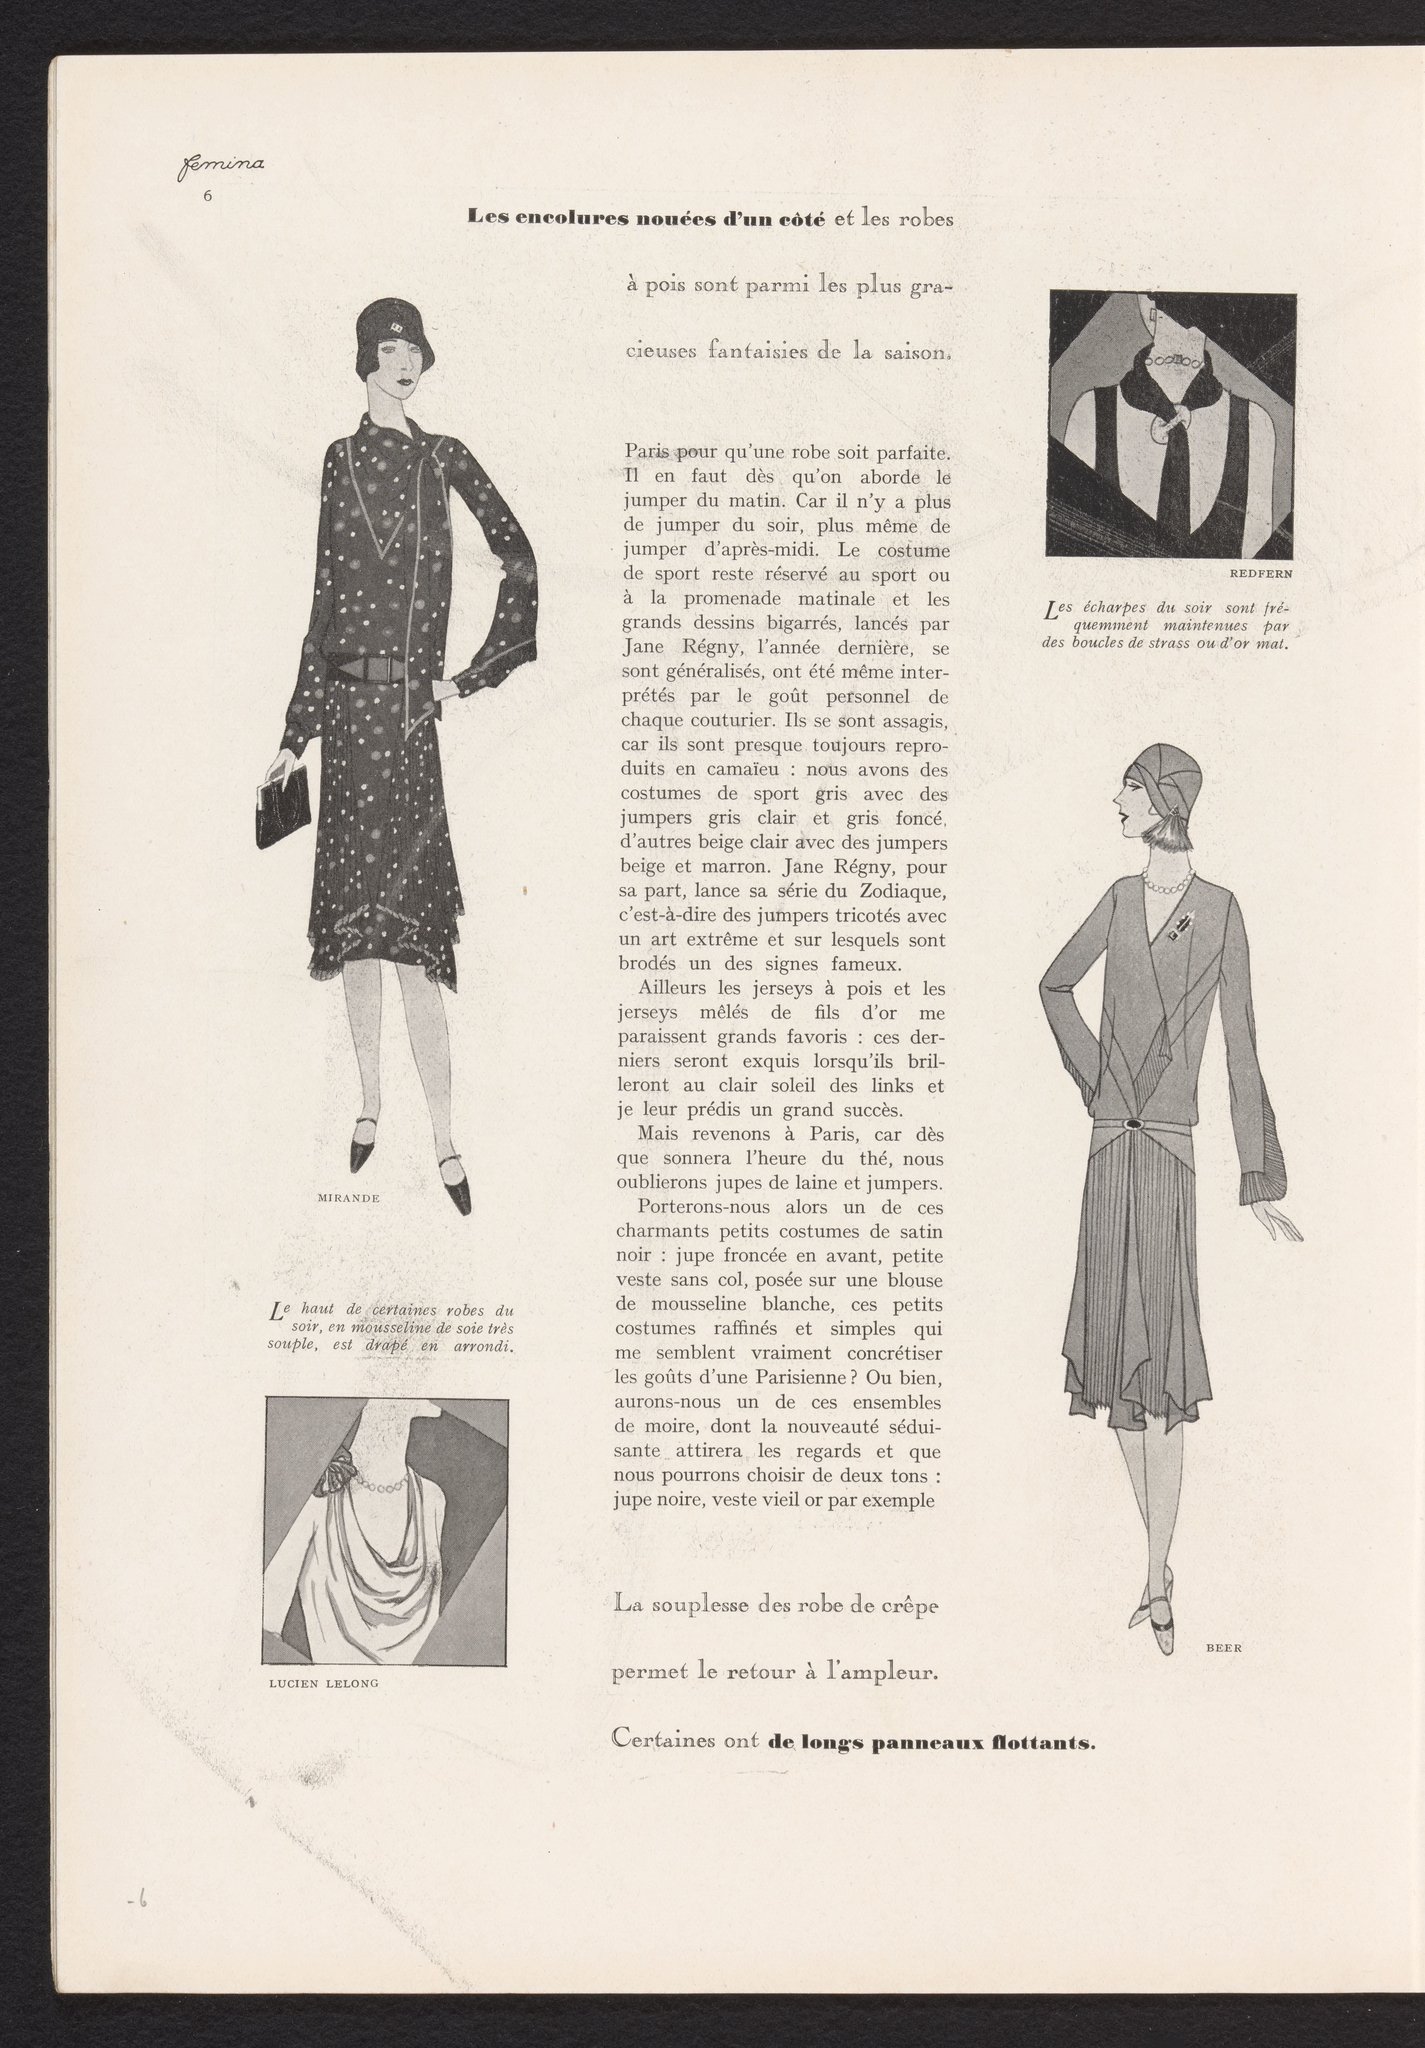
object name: fashion print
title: Femina, Mars 1928: 6: twee vrouwen in jurken van Mirande en Beer met twee details van jurken van Lucien Lelong en Redfern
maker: pierre laffitte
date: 1928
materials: paper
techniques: letterpress printing, photography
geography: paris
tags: fashion plates, standing figure - aa - female human figure, dress, gown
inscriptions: date